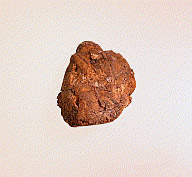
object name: head of a woman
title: Pendant: woman's head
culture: italic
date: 500-401 BCE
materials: amber